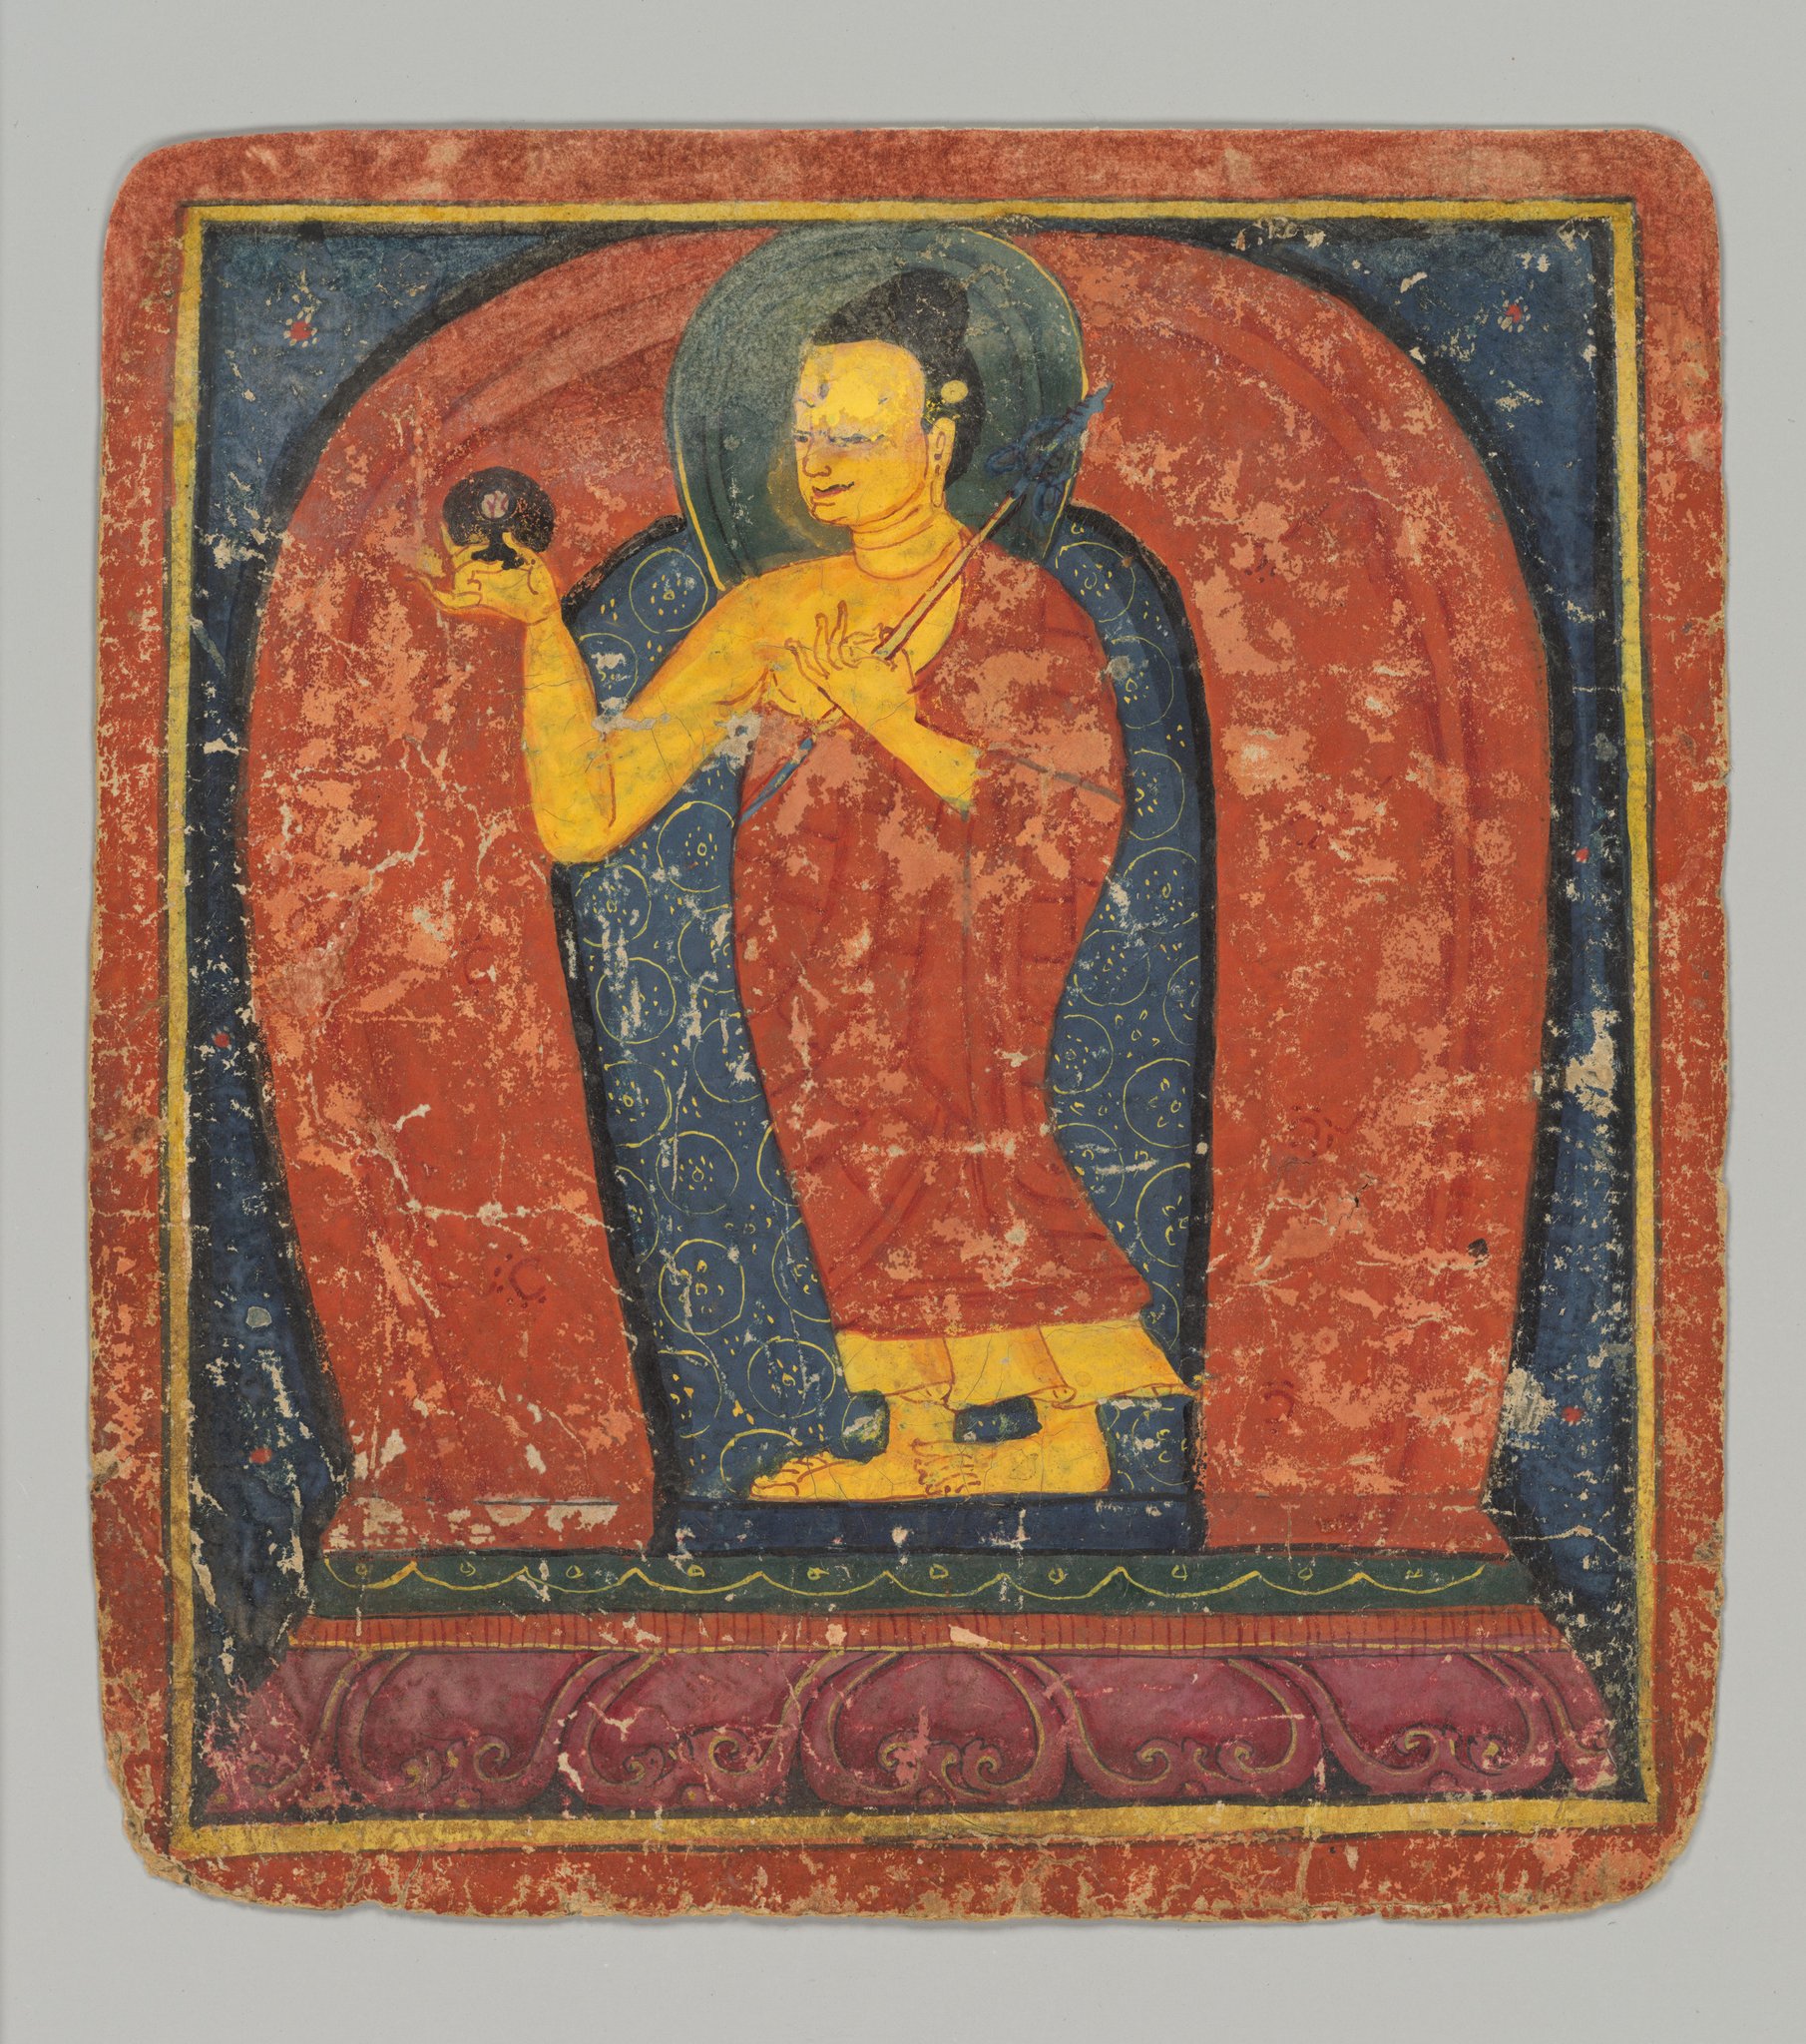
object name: initiation card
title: Initiation Card (Tsakalis)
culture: tibetan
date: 1401-1433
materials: paper, watercolor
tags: buddhism